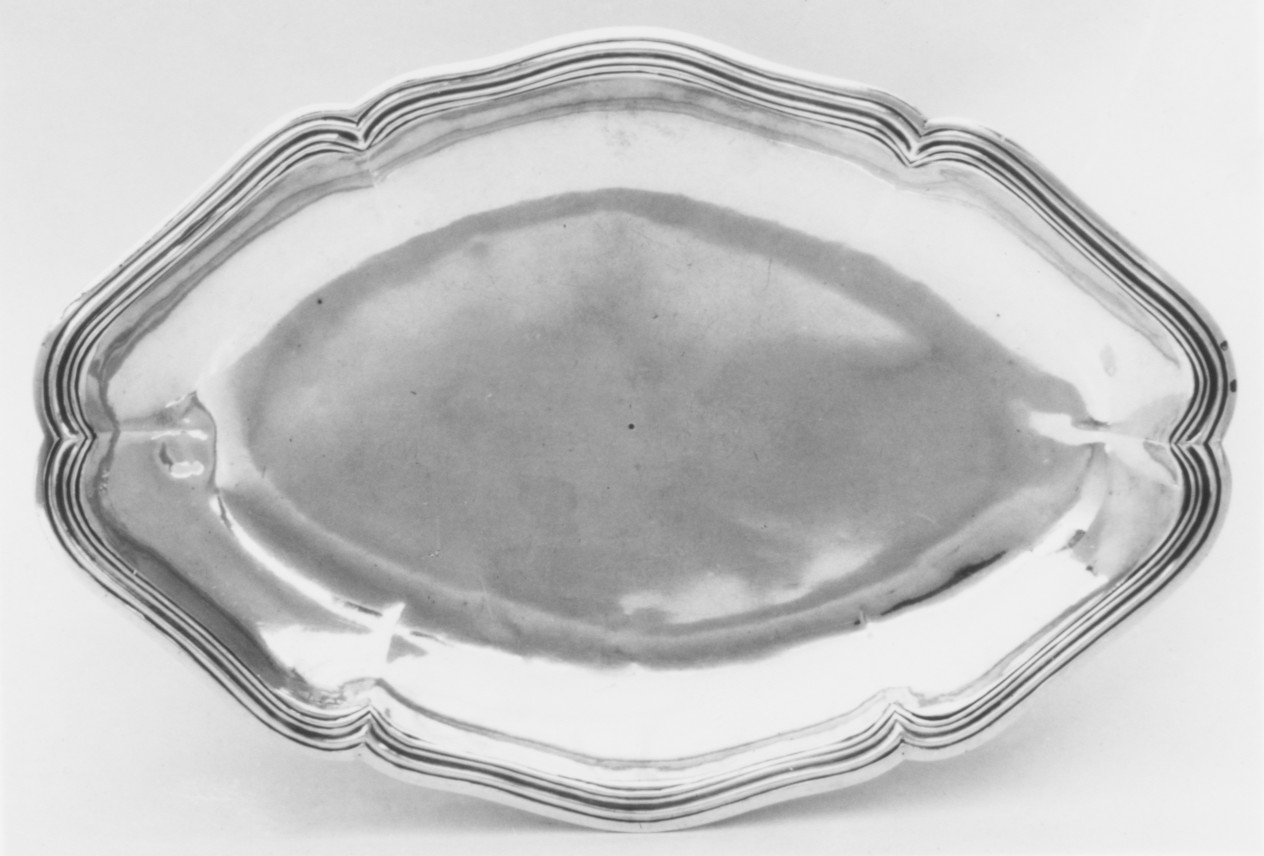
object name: tray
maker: denis lachèse (or la chèse, lacheze)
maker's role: maker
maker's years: 1713-1813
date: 1785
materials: silver